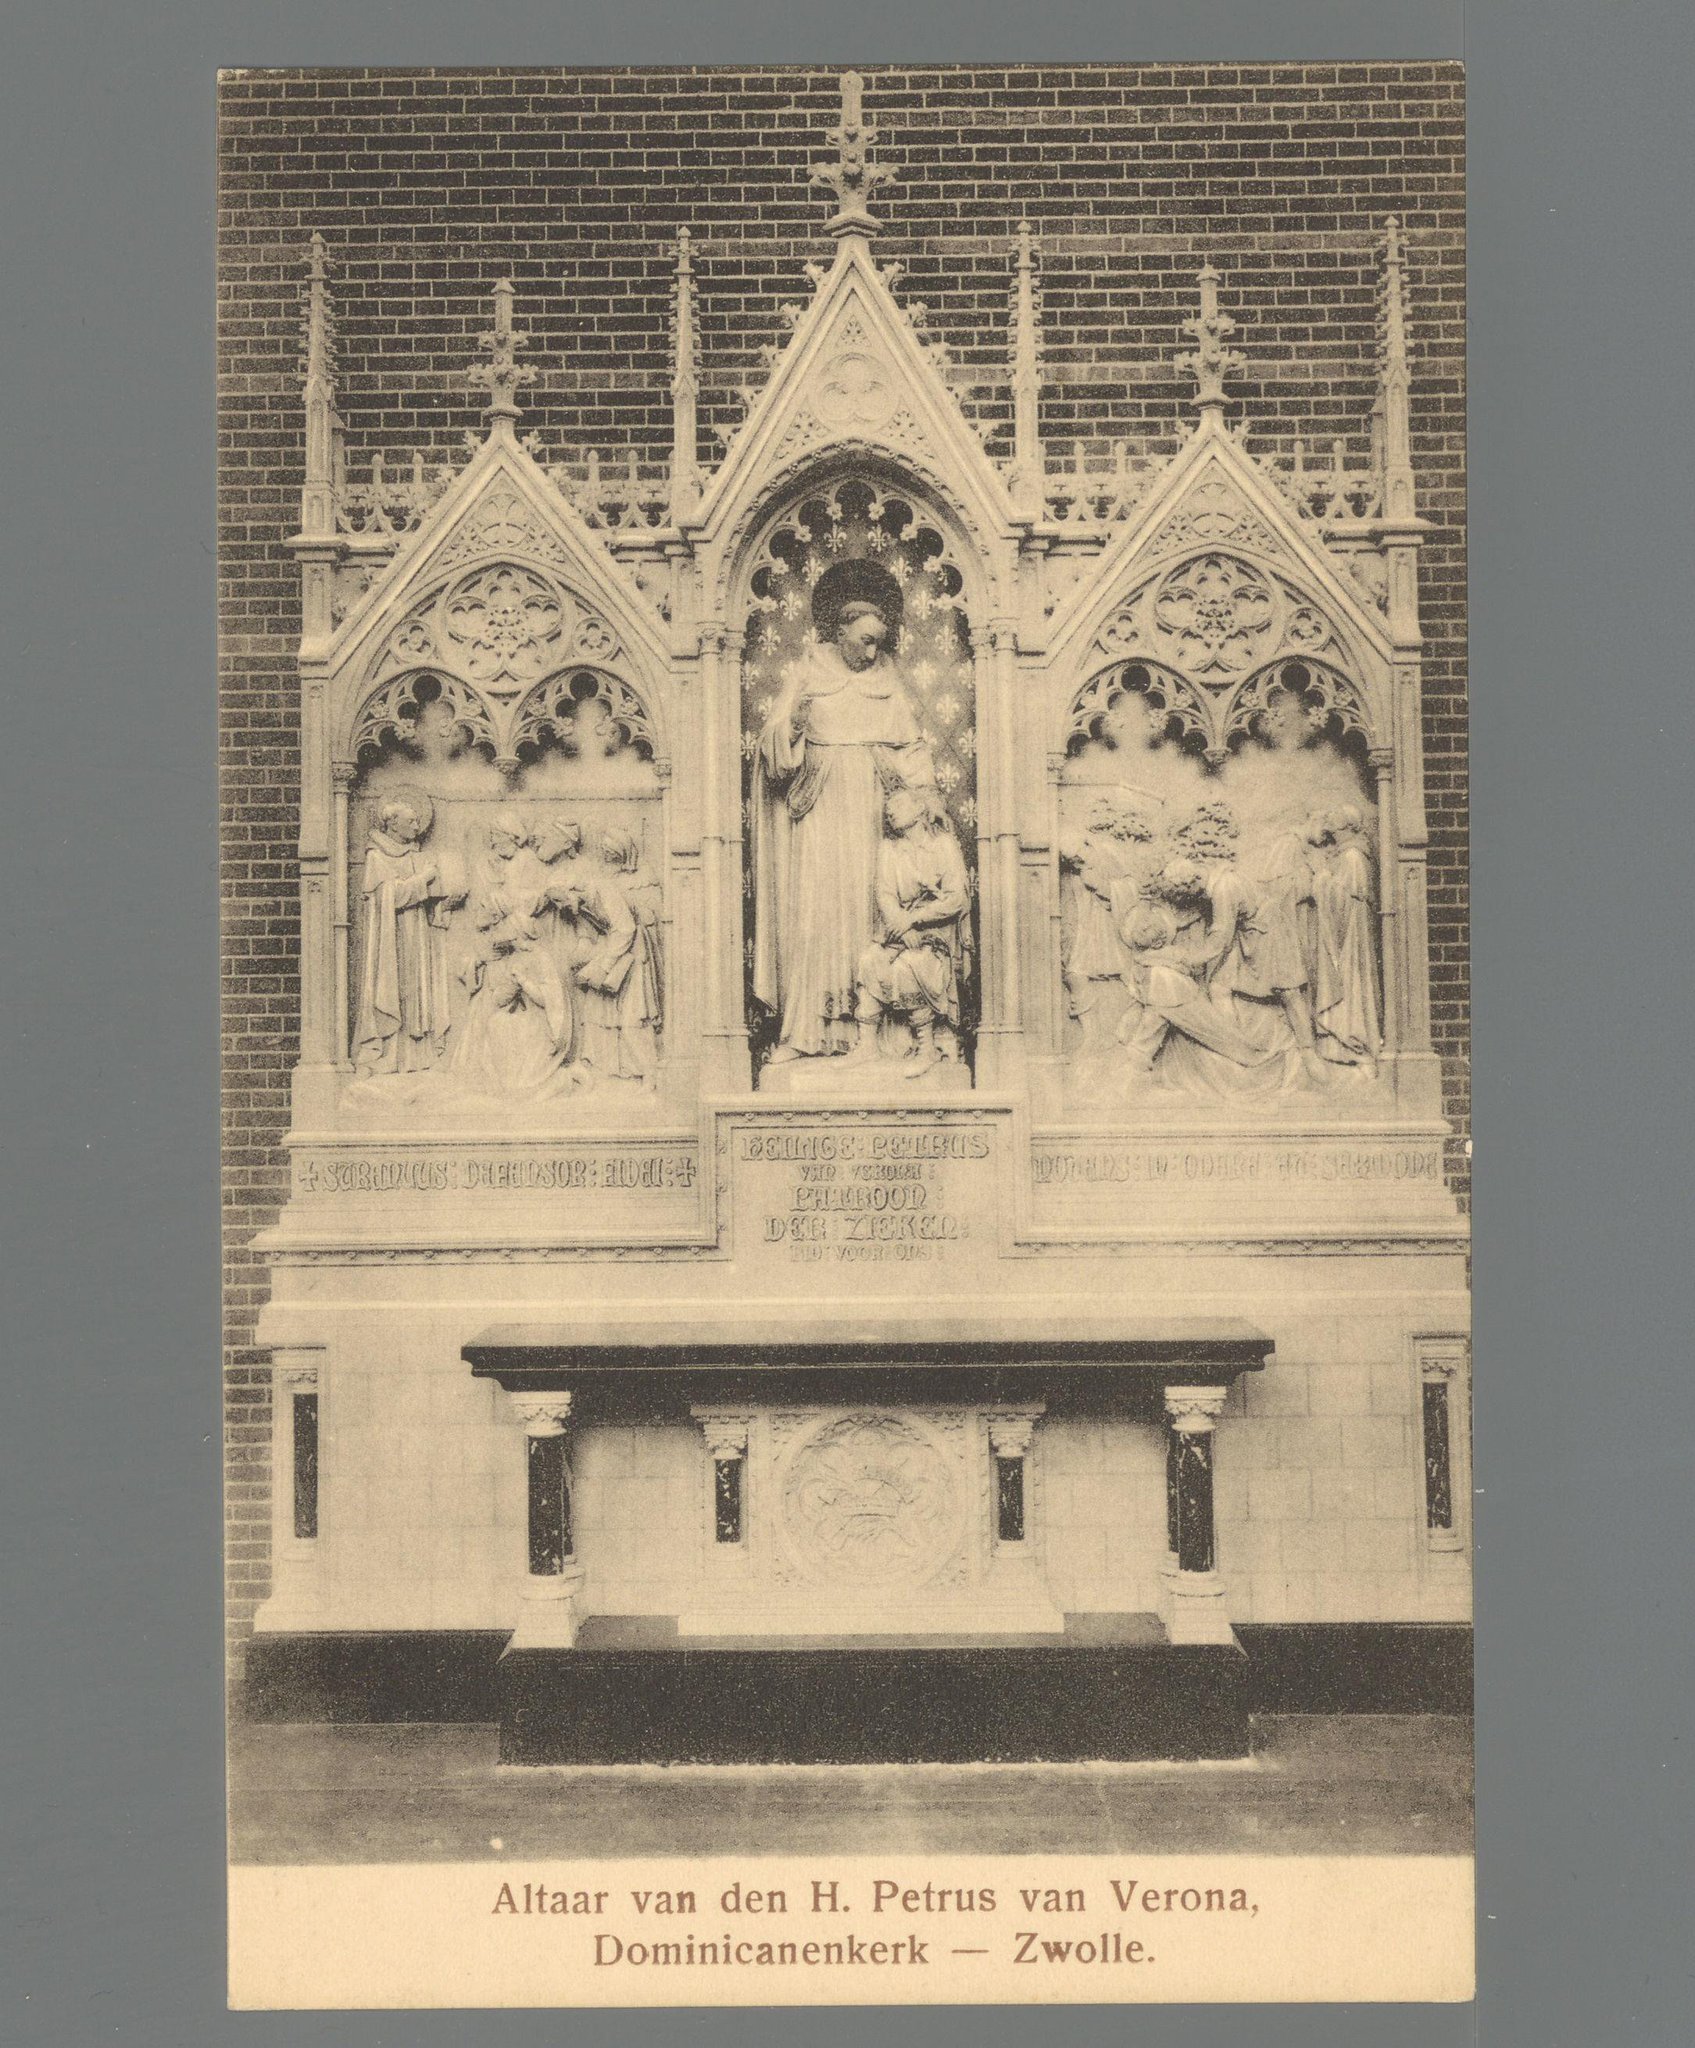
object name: ansichtkaart, prentbriefkaart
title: Altaar van den H. Petrus van Verona, Dominicanenkerk - Zwolle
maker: Anonymous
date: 1905-1930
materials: cardboard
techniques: photograph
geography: zwolle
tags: interior of church, altar